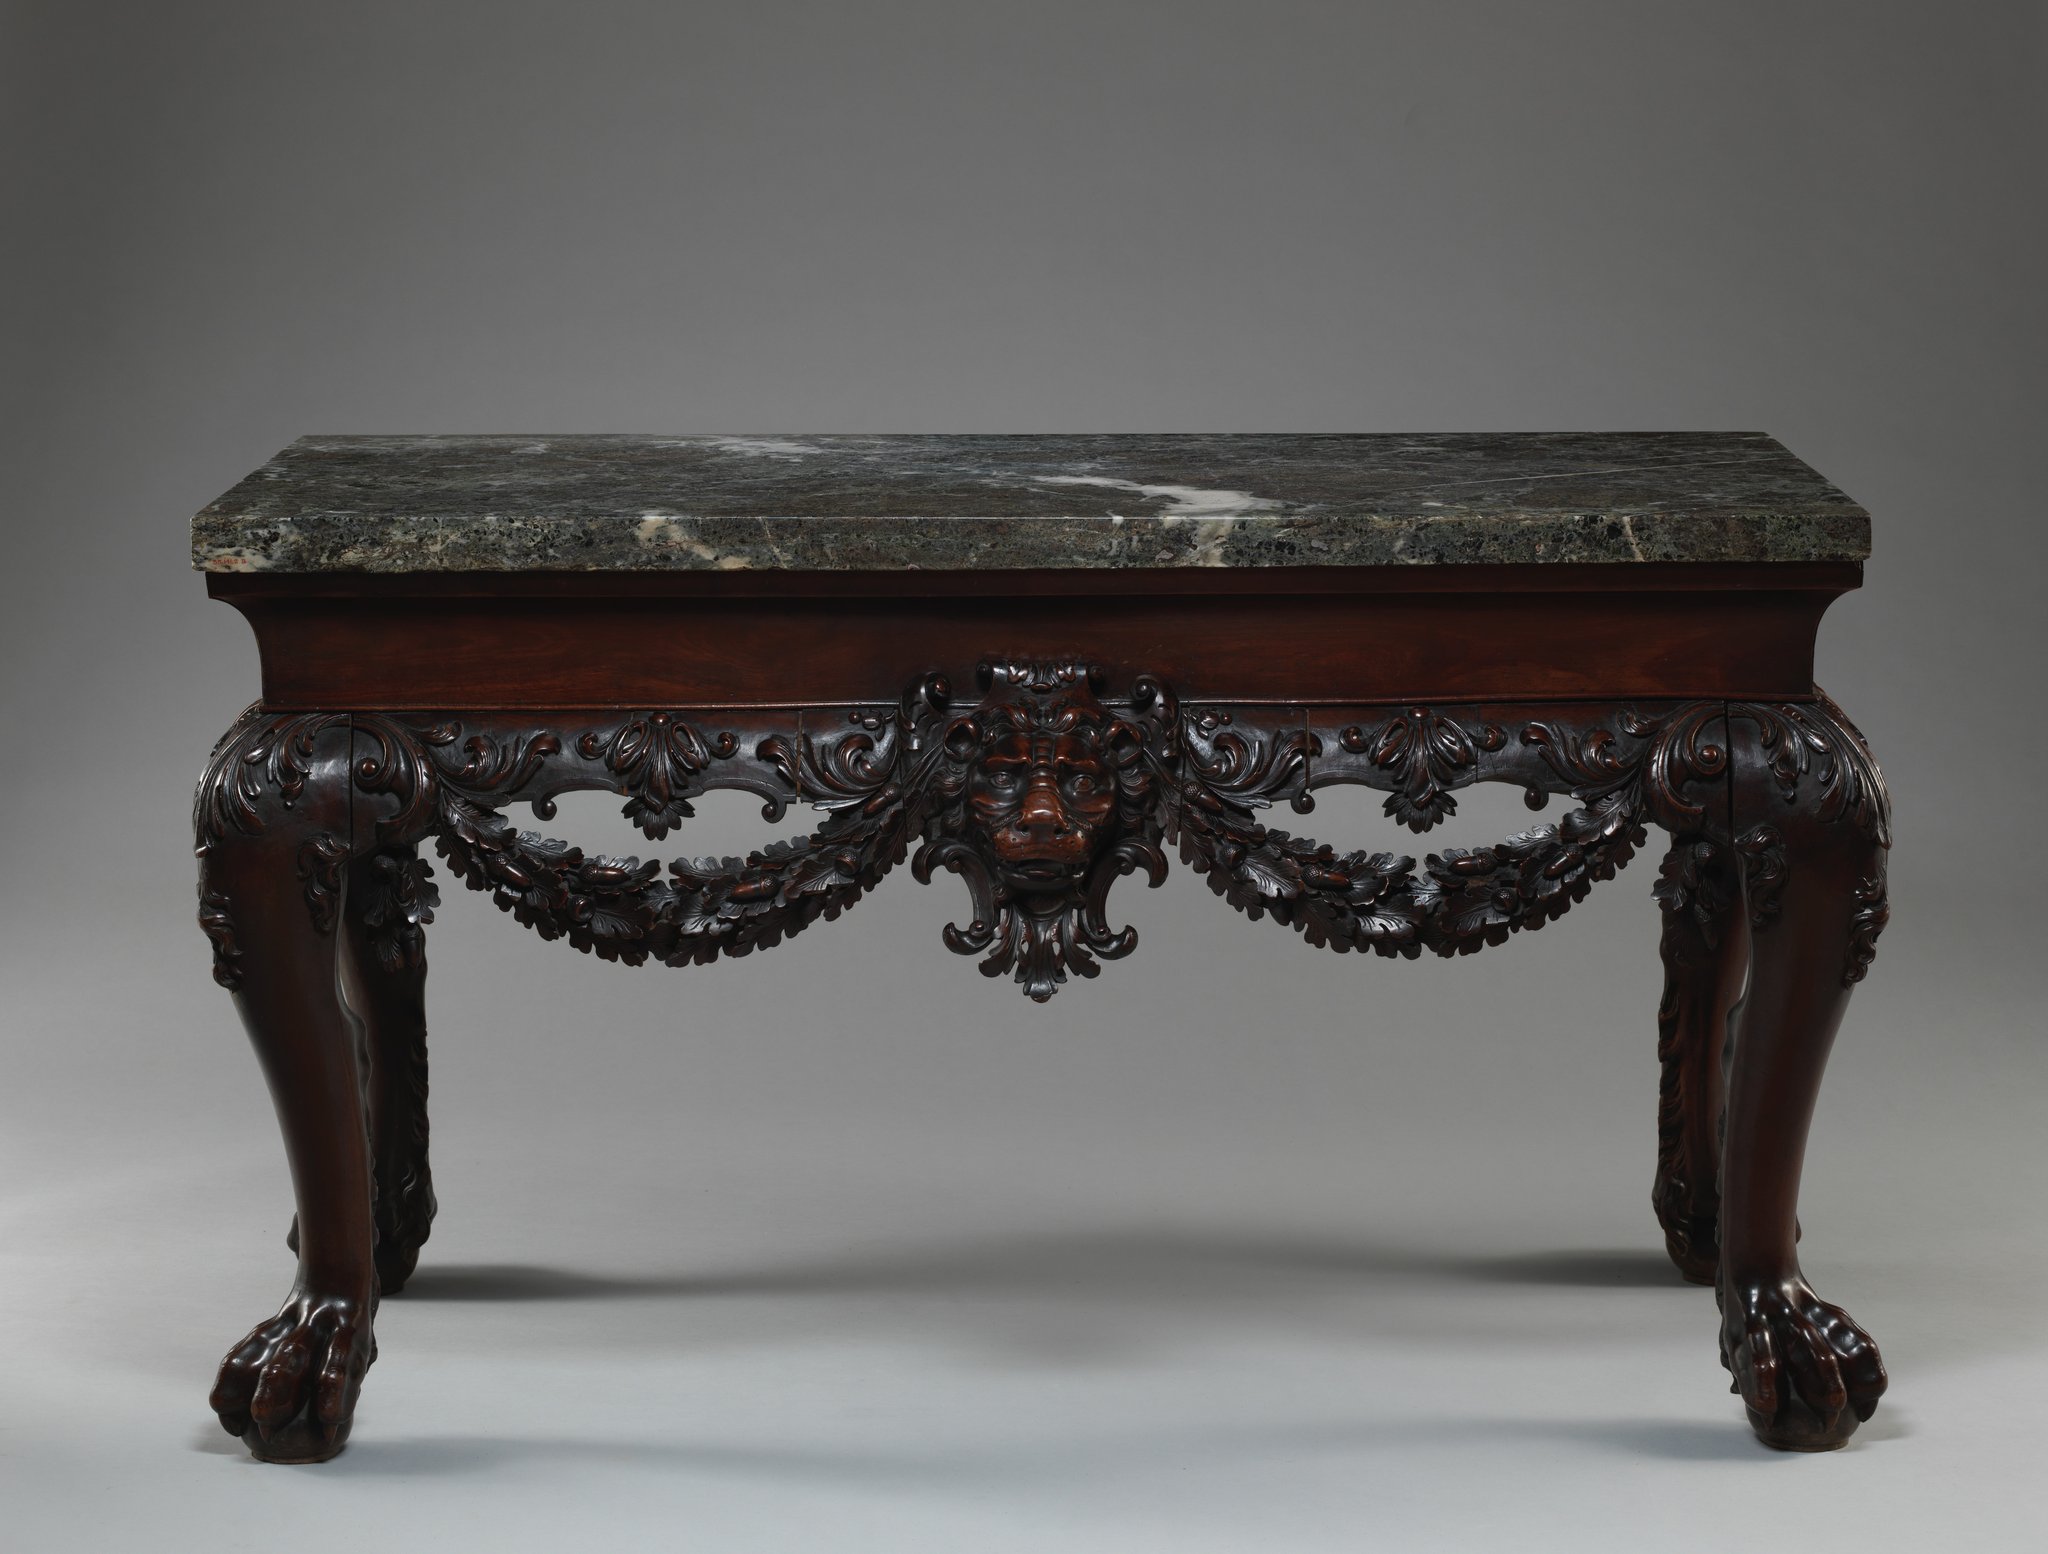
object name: side table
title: Side table (one of a pair)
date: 1740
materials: wood, marble